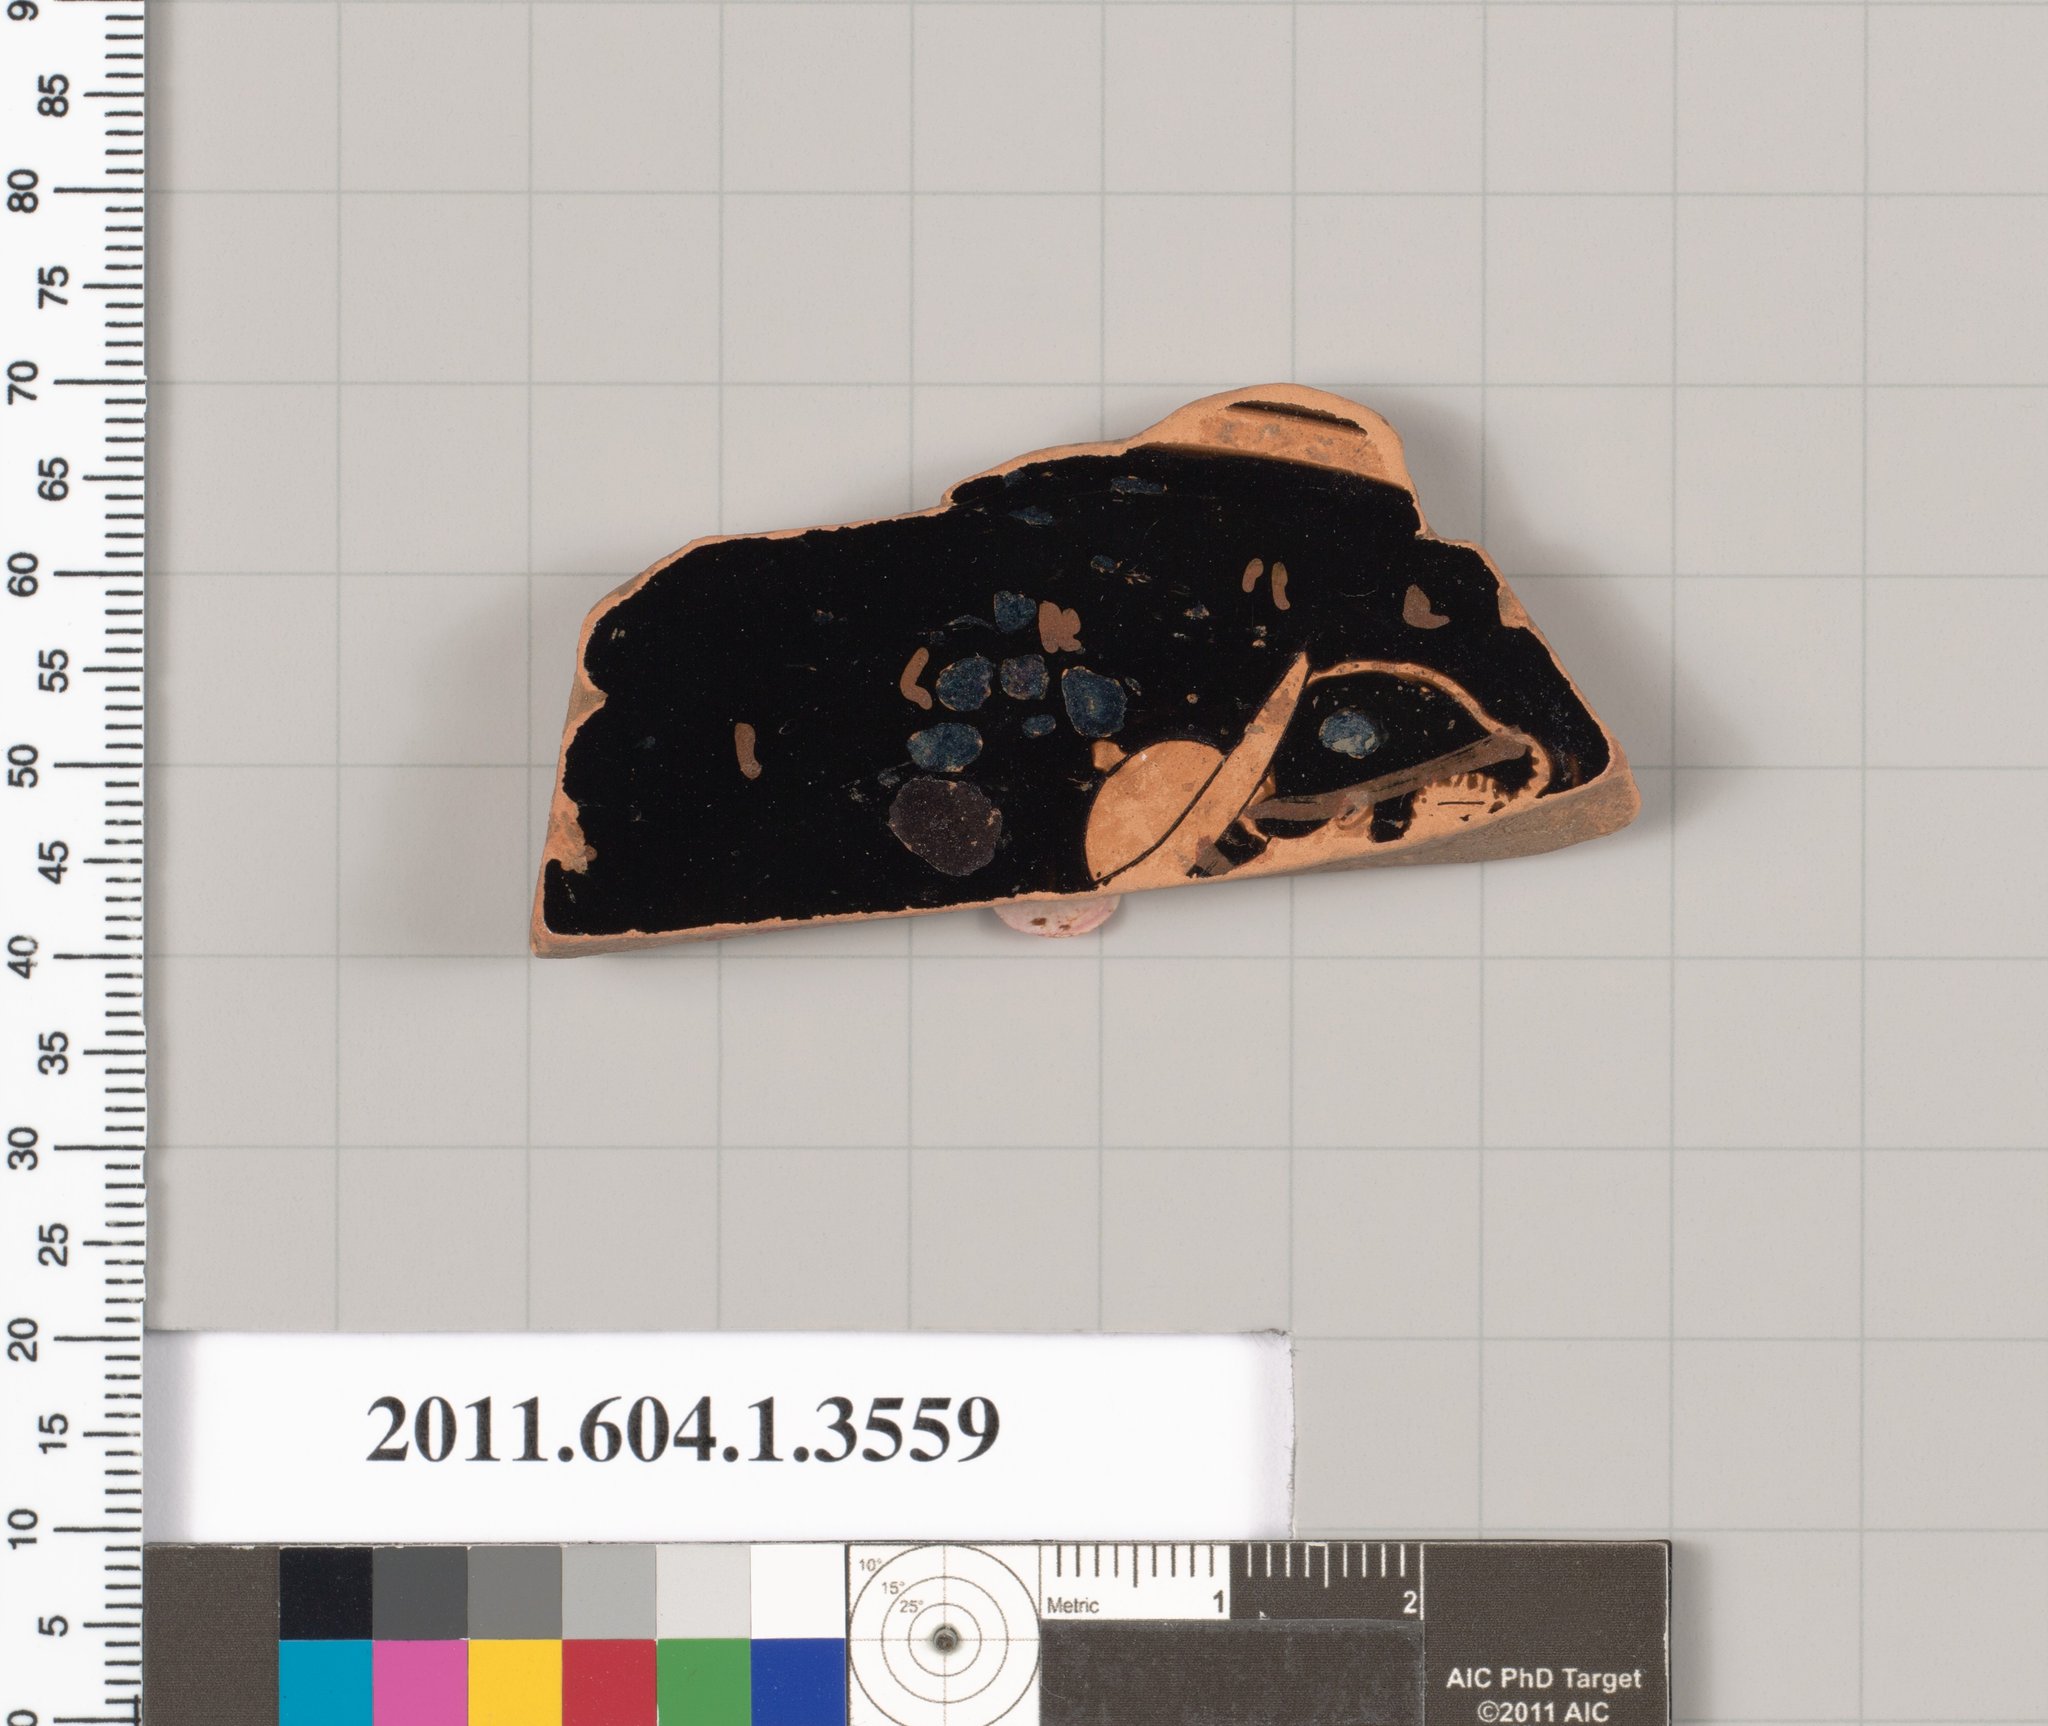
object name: kylix fragment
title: Terracotta fragment of a kylix (drinking cup)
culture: greek, attic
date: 490-480 BCE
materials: terracotta